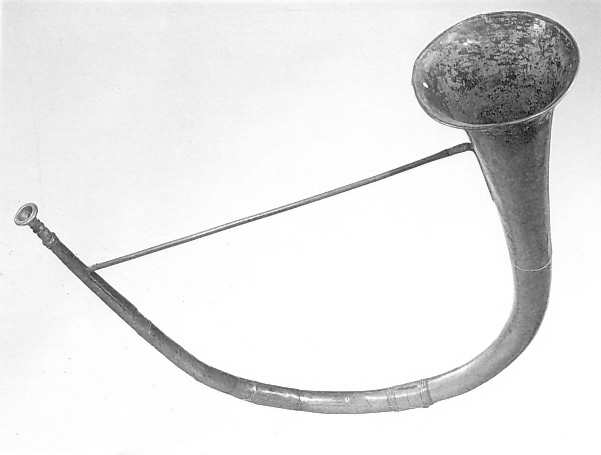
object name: half moon bugle or flügelhorn in d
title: Half Moon (bugle or flügelhorn) in D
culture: german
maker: erdmuthe juliane liebel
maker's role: maker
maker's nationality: german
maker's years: 1810-1815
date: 1813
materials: brass, nickel, silver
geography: germany